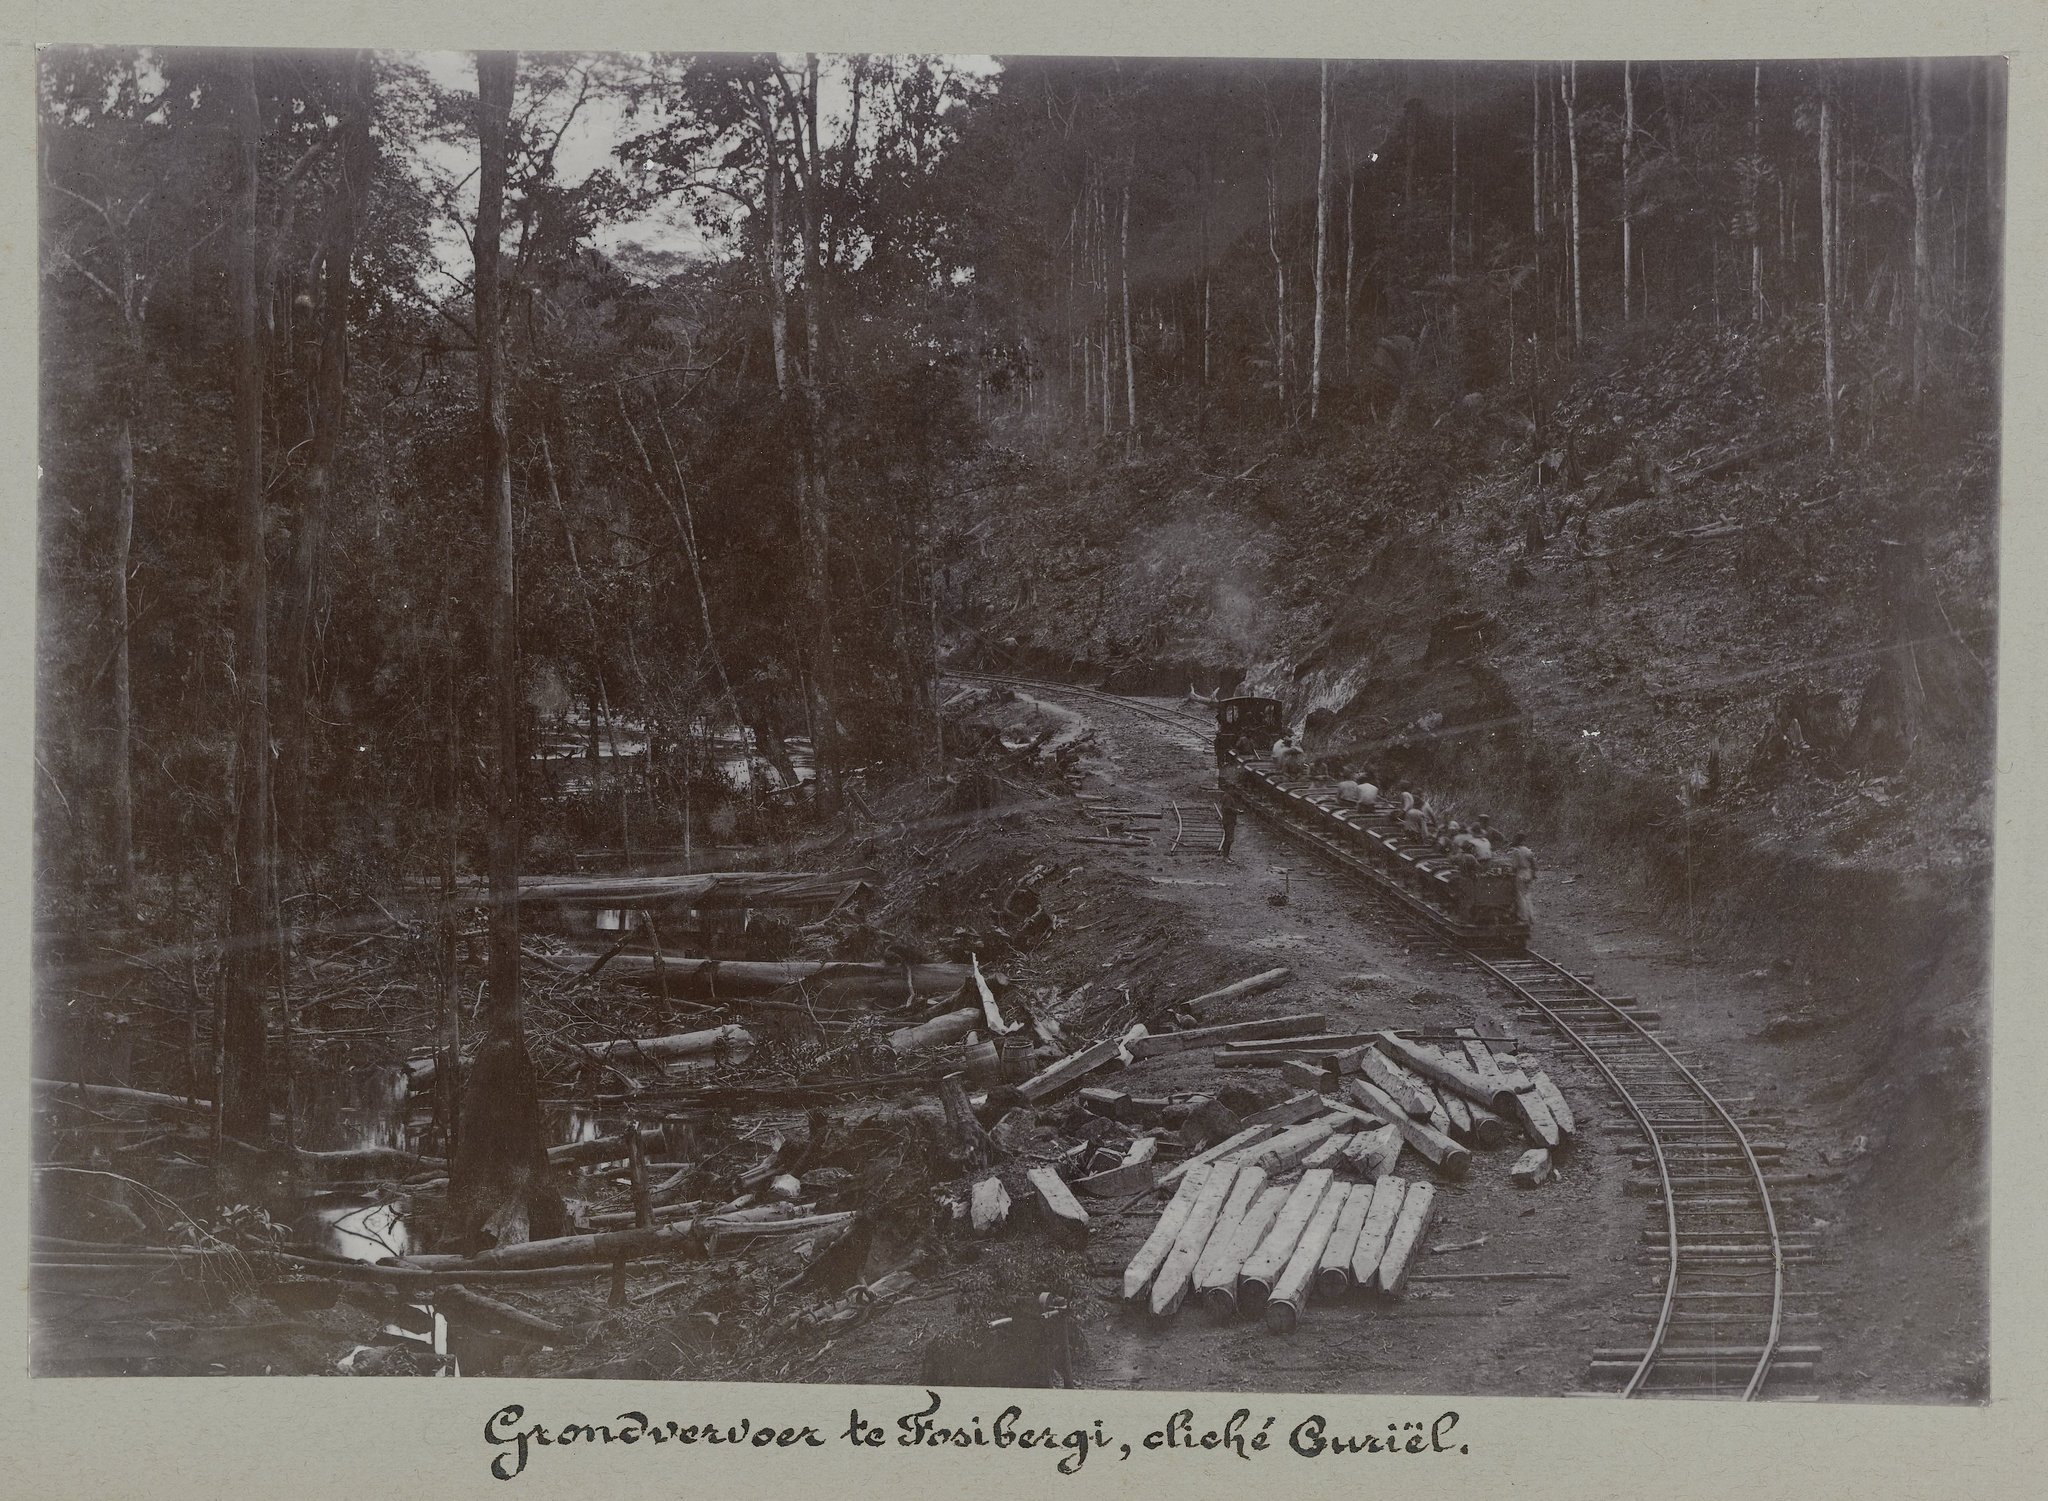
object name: photograph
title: Grondvervoer te Fosibergi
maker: augusta curiel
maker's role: fotograaf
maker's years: 1873-1937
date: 1900-1913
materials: photographic support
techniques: collodion silver print, gelatin silver print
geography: suriname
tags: suriname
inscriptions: inscription: ‘Grondvervoer te Fosibergi, cliché Curiël.’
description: Spoorlijn voor grondvervoer door het bos, volgens het onderschrift te Fosibergi. Onderdeel van het fotoalbum Souvenir de Voyage (deel 3), over het leven van de familie Dooyer in en rond de plantage Ma Retraite in Suriname in de jaren 1906-1913.